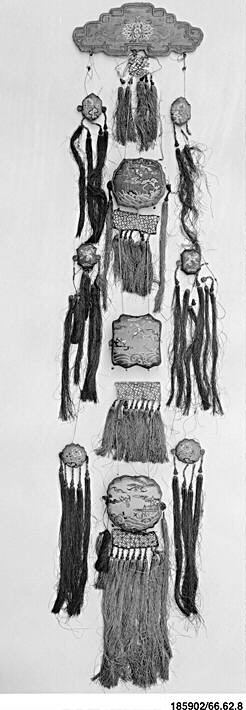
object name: wall hanging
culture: chinese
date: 1701-1733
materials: ceramic, silk, metal, wood